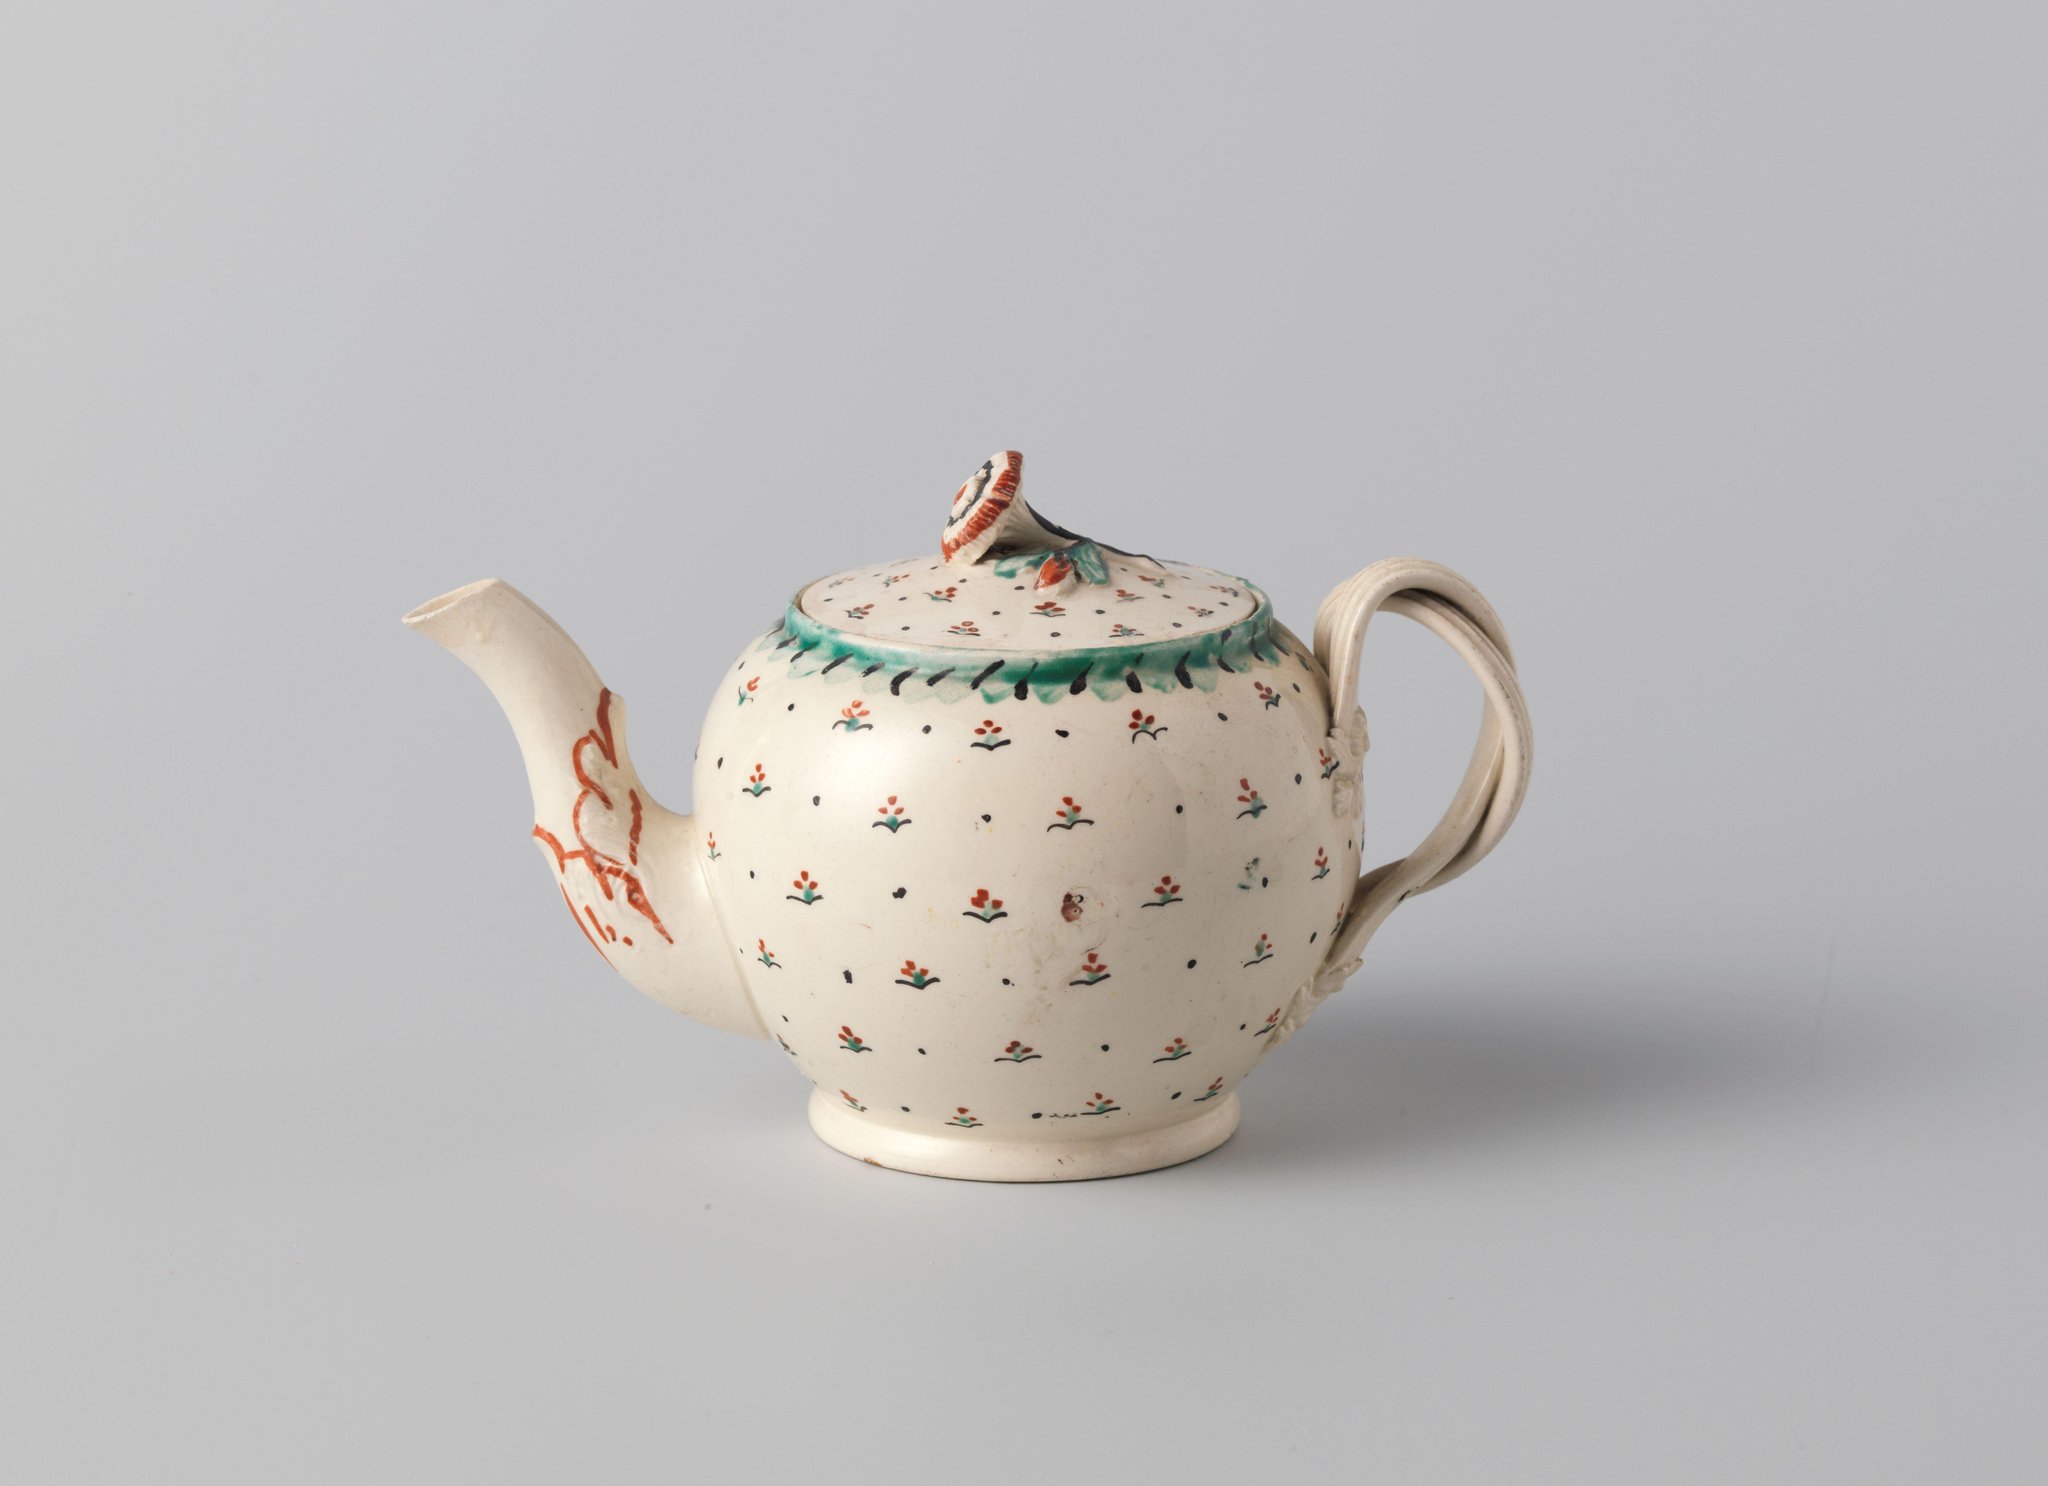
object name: teapot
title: Theepot van hardgebakken aardewerk met een veelkleurige decoratie op de glazuur, creamware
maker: Anonymous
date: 1770-1790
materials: earthenware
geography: england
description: Bolvormige theepot van hardgebakken aardewerk. De theepot heeft een gevlochten oor een S-vormige tuit. De theepot is in rood, zwart en groen beschilderd met kleine gestileerde bloemen. De tuit heeft bladeren (?) in reliëf.